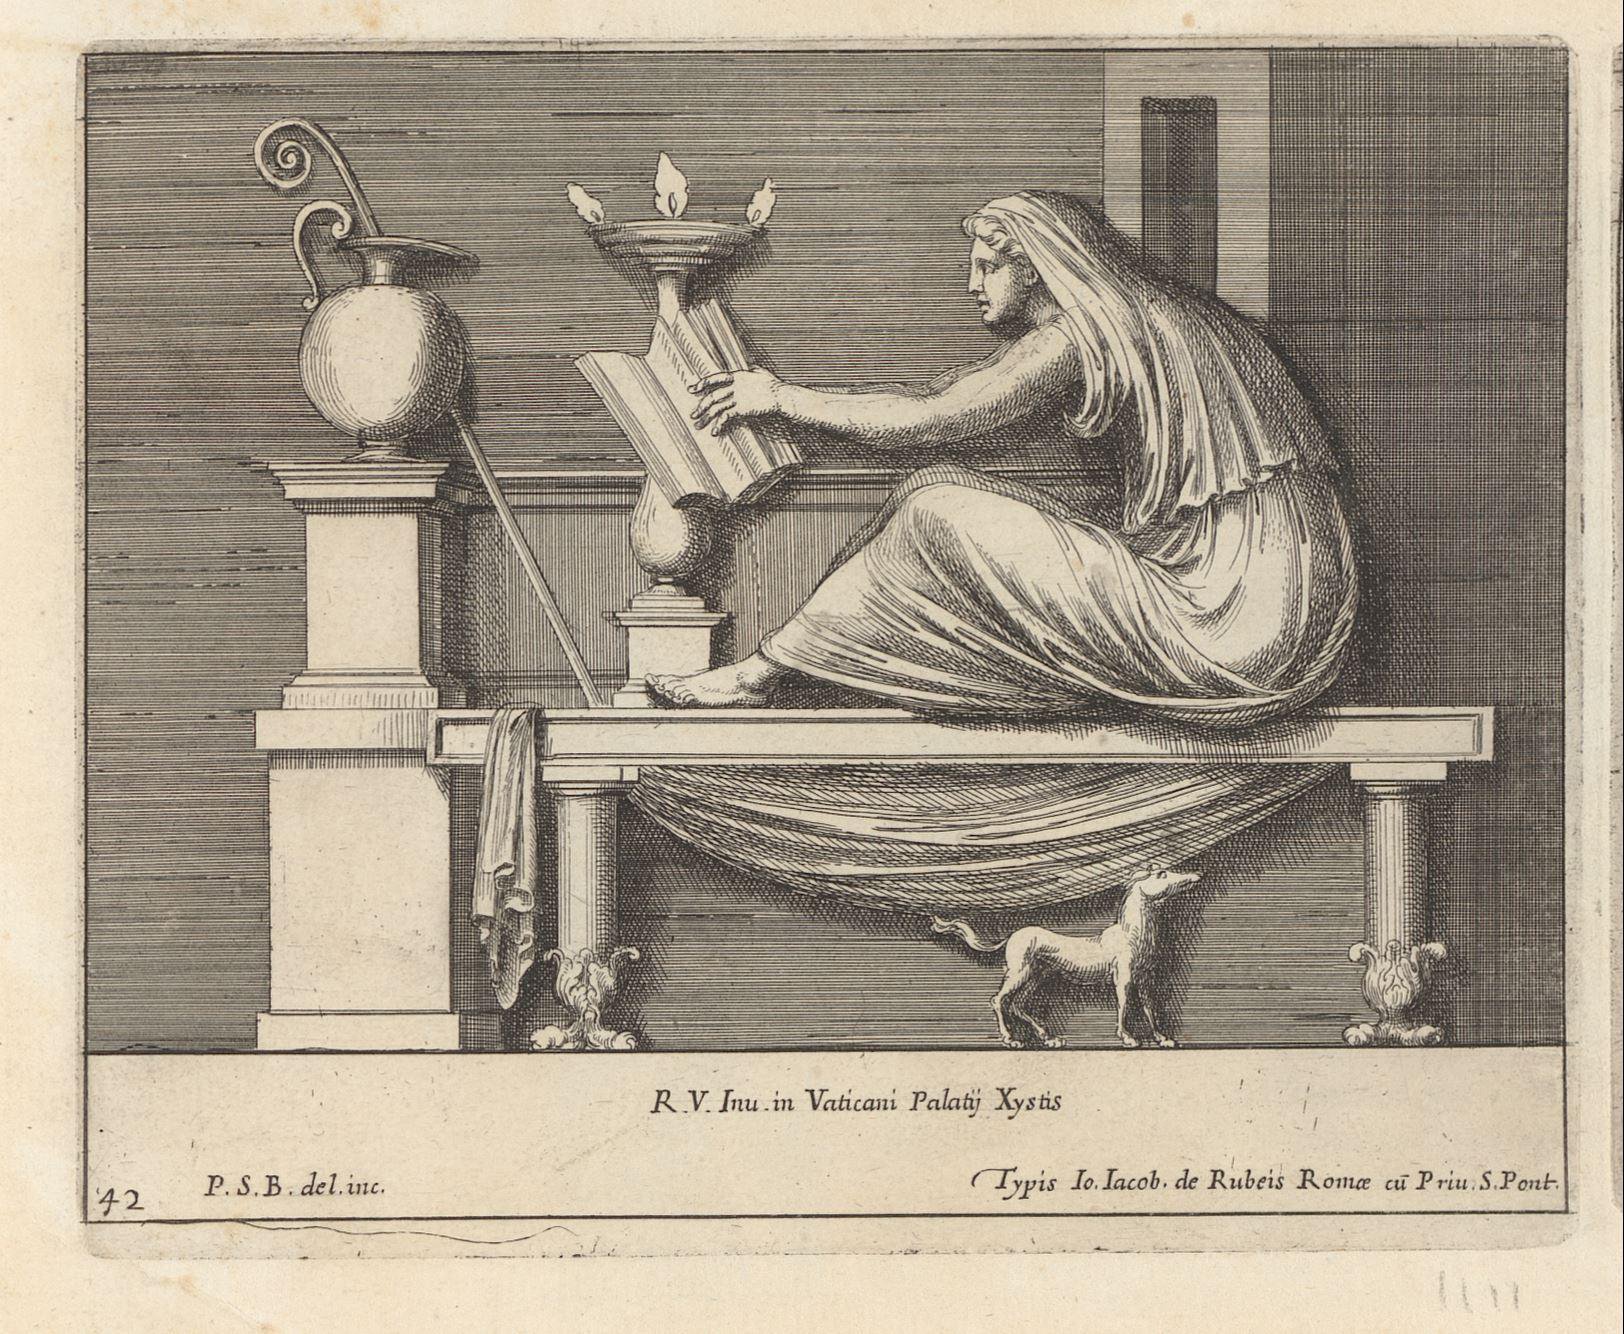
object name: album leaf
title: Reliëfs in de Loggia van Rafaël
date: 1645-1700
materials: paper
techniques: engraving, etching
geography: italy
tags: adult woman, book, sitting on an elevation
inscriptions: number: ‘20’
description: Een vrouwenfiguur met een sluier zittend op een bankje. In haar handen houdt zijn een boek. Links staan een vaas en een staf. Prent maakt deel uit van een album.